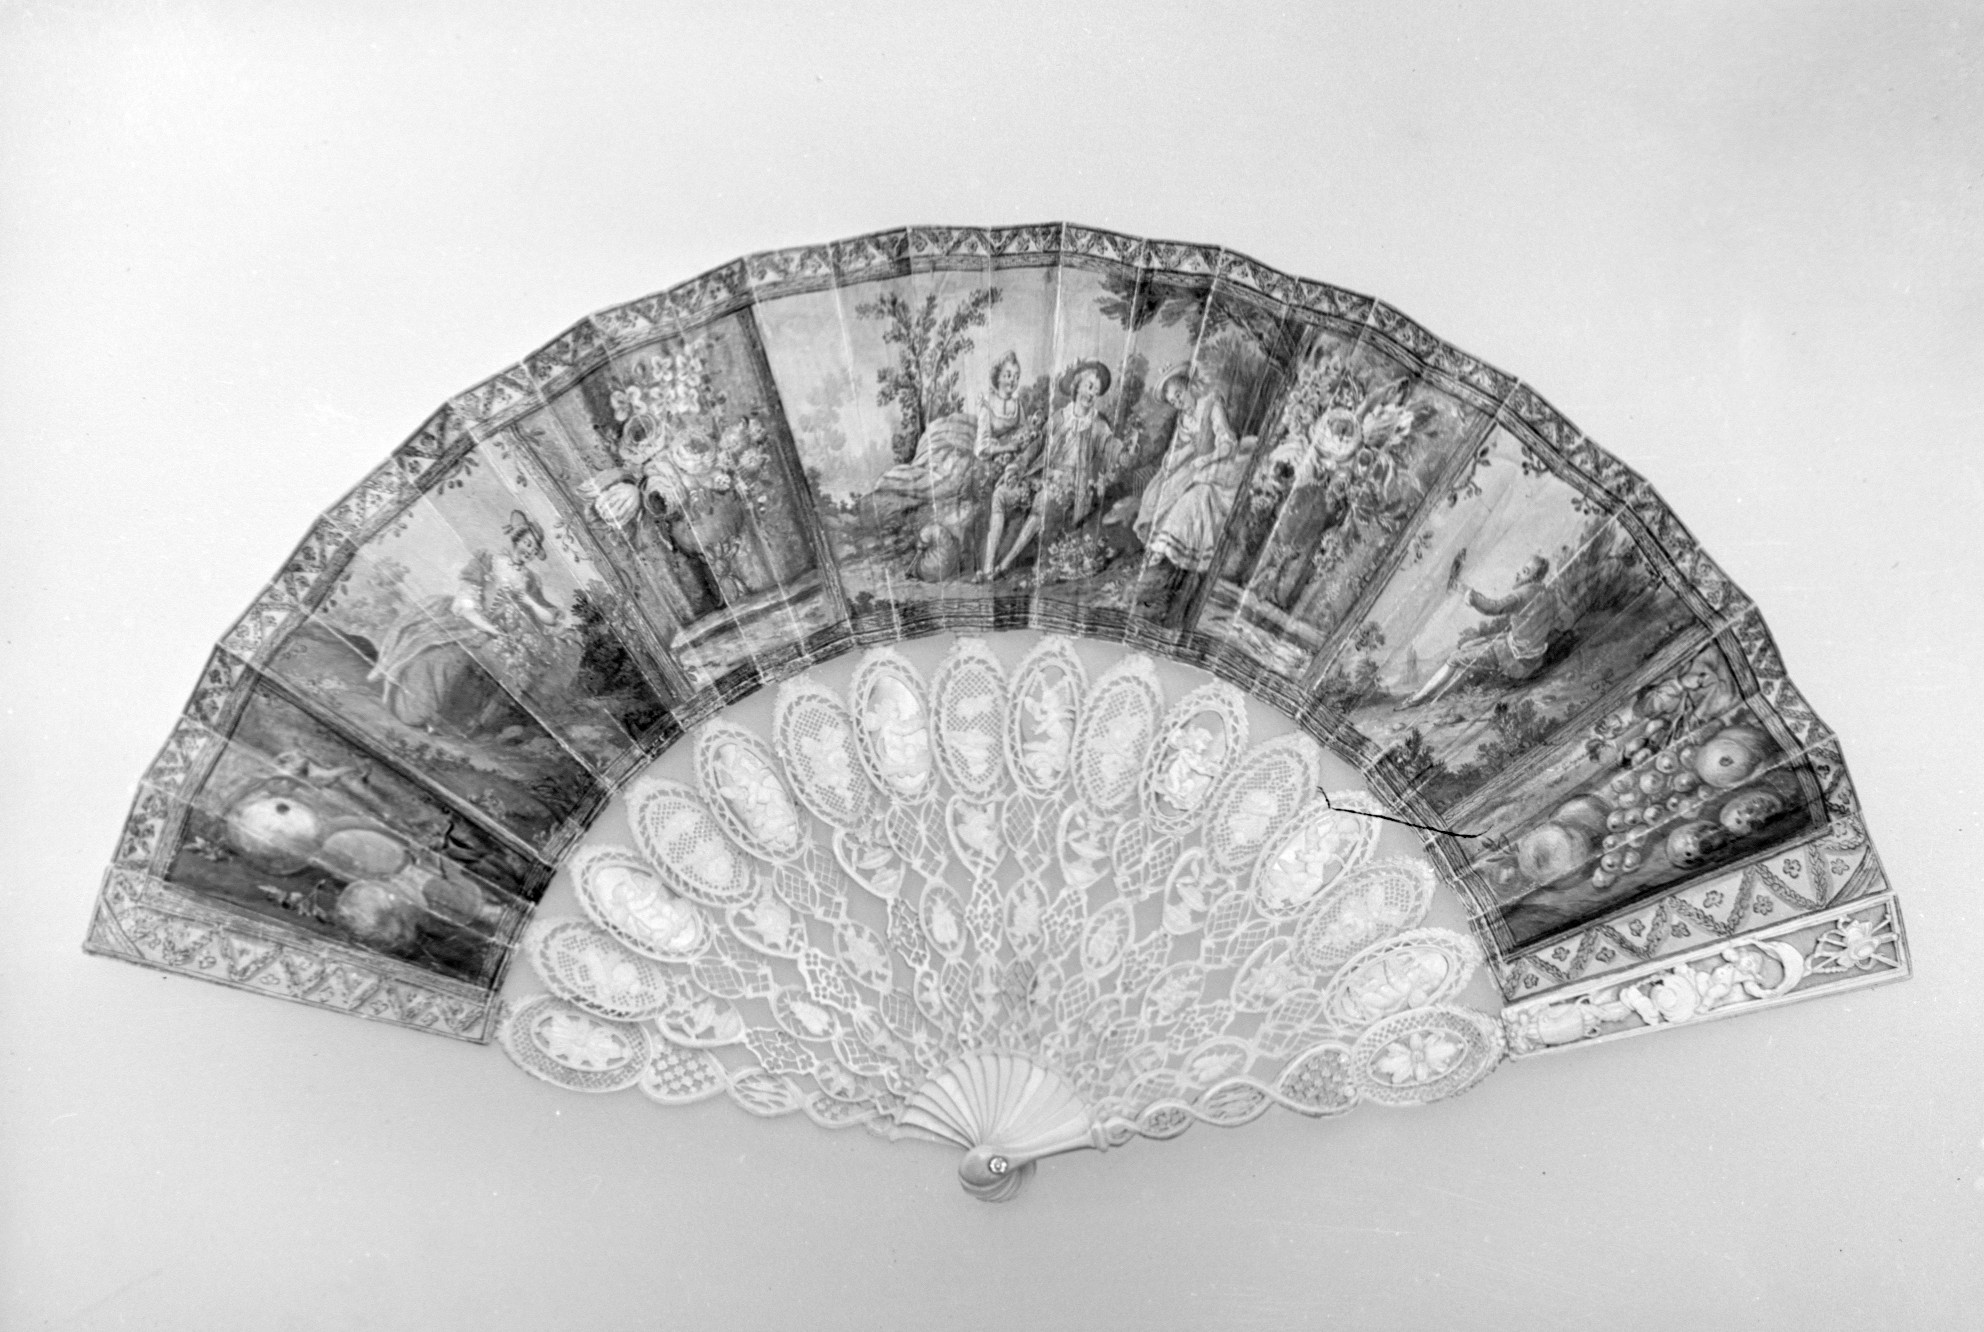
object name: fan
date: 1751-1775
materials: ivory, mother of pearl, parchment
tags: fruit,men,women,flowers